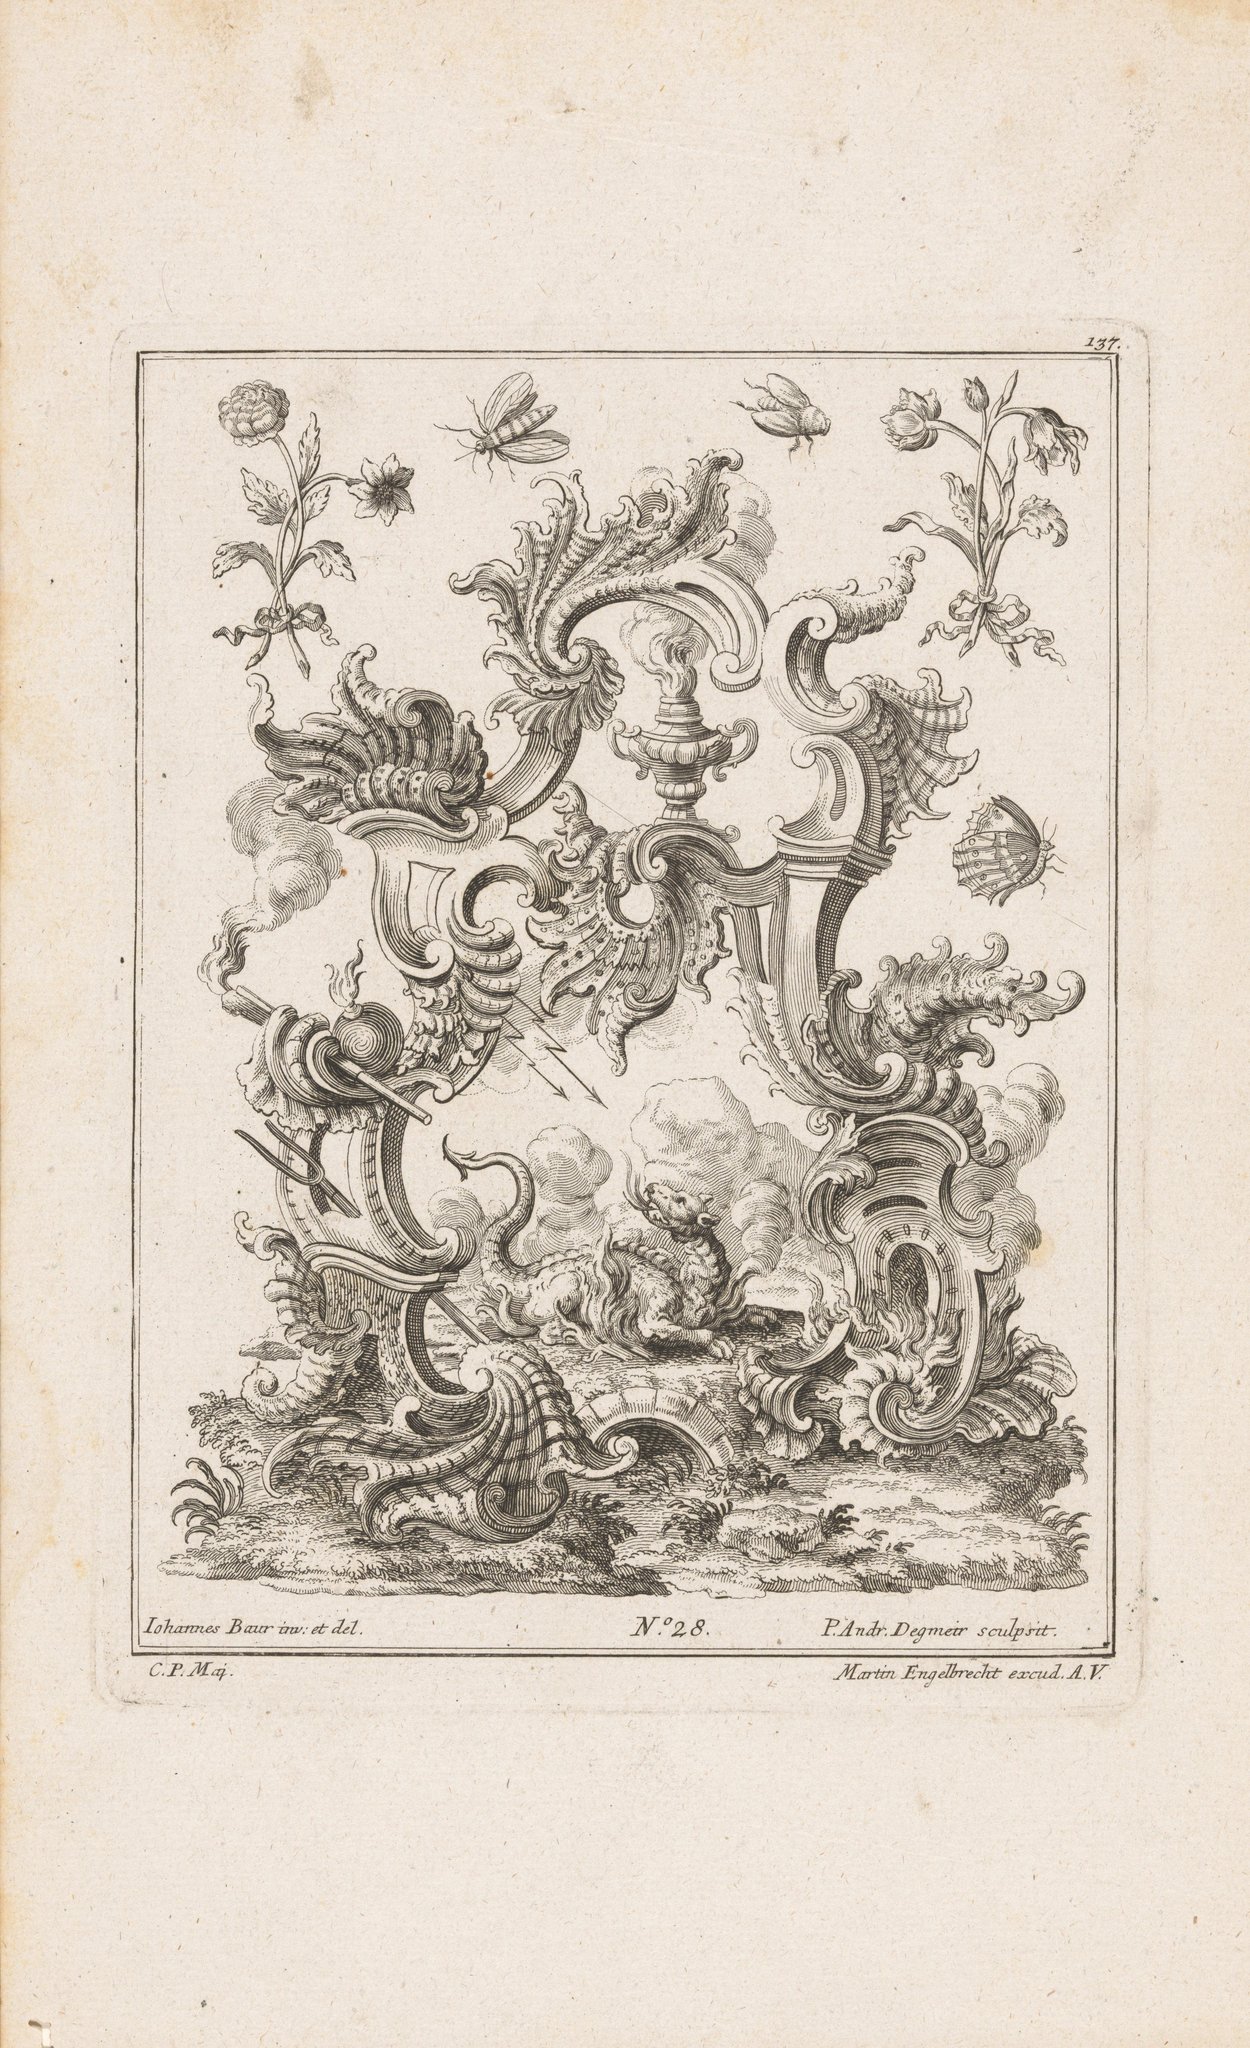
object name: print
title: Rocaille met een vuurspuwende draak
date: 1719-1749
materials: paper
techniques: etching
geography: augsburg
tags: rocaille ornament, fire (one of the four elements), dragon, insects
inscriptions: collector's mark: Lugt 2228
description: De vuurspuwende draak wordt omgeven door een rocaille. De rocaille is versierd met voorwerpen die samenhangen met het element vuur, zoals een fakkel. Bovenaan bloemen en insecten. Midden onder 28 genummerd. Rechtsboven 137 genummerd.